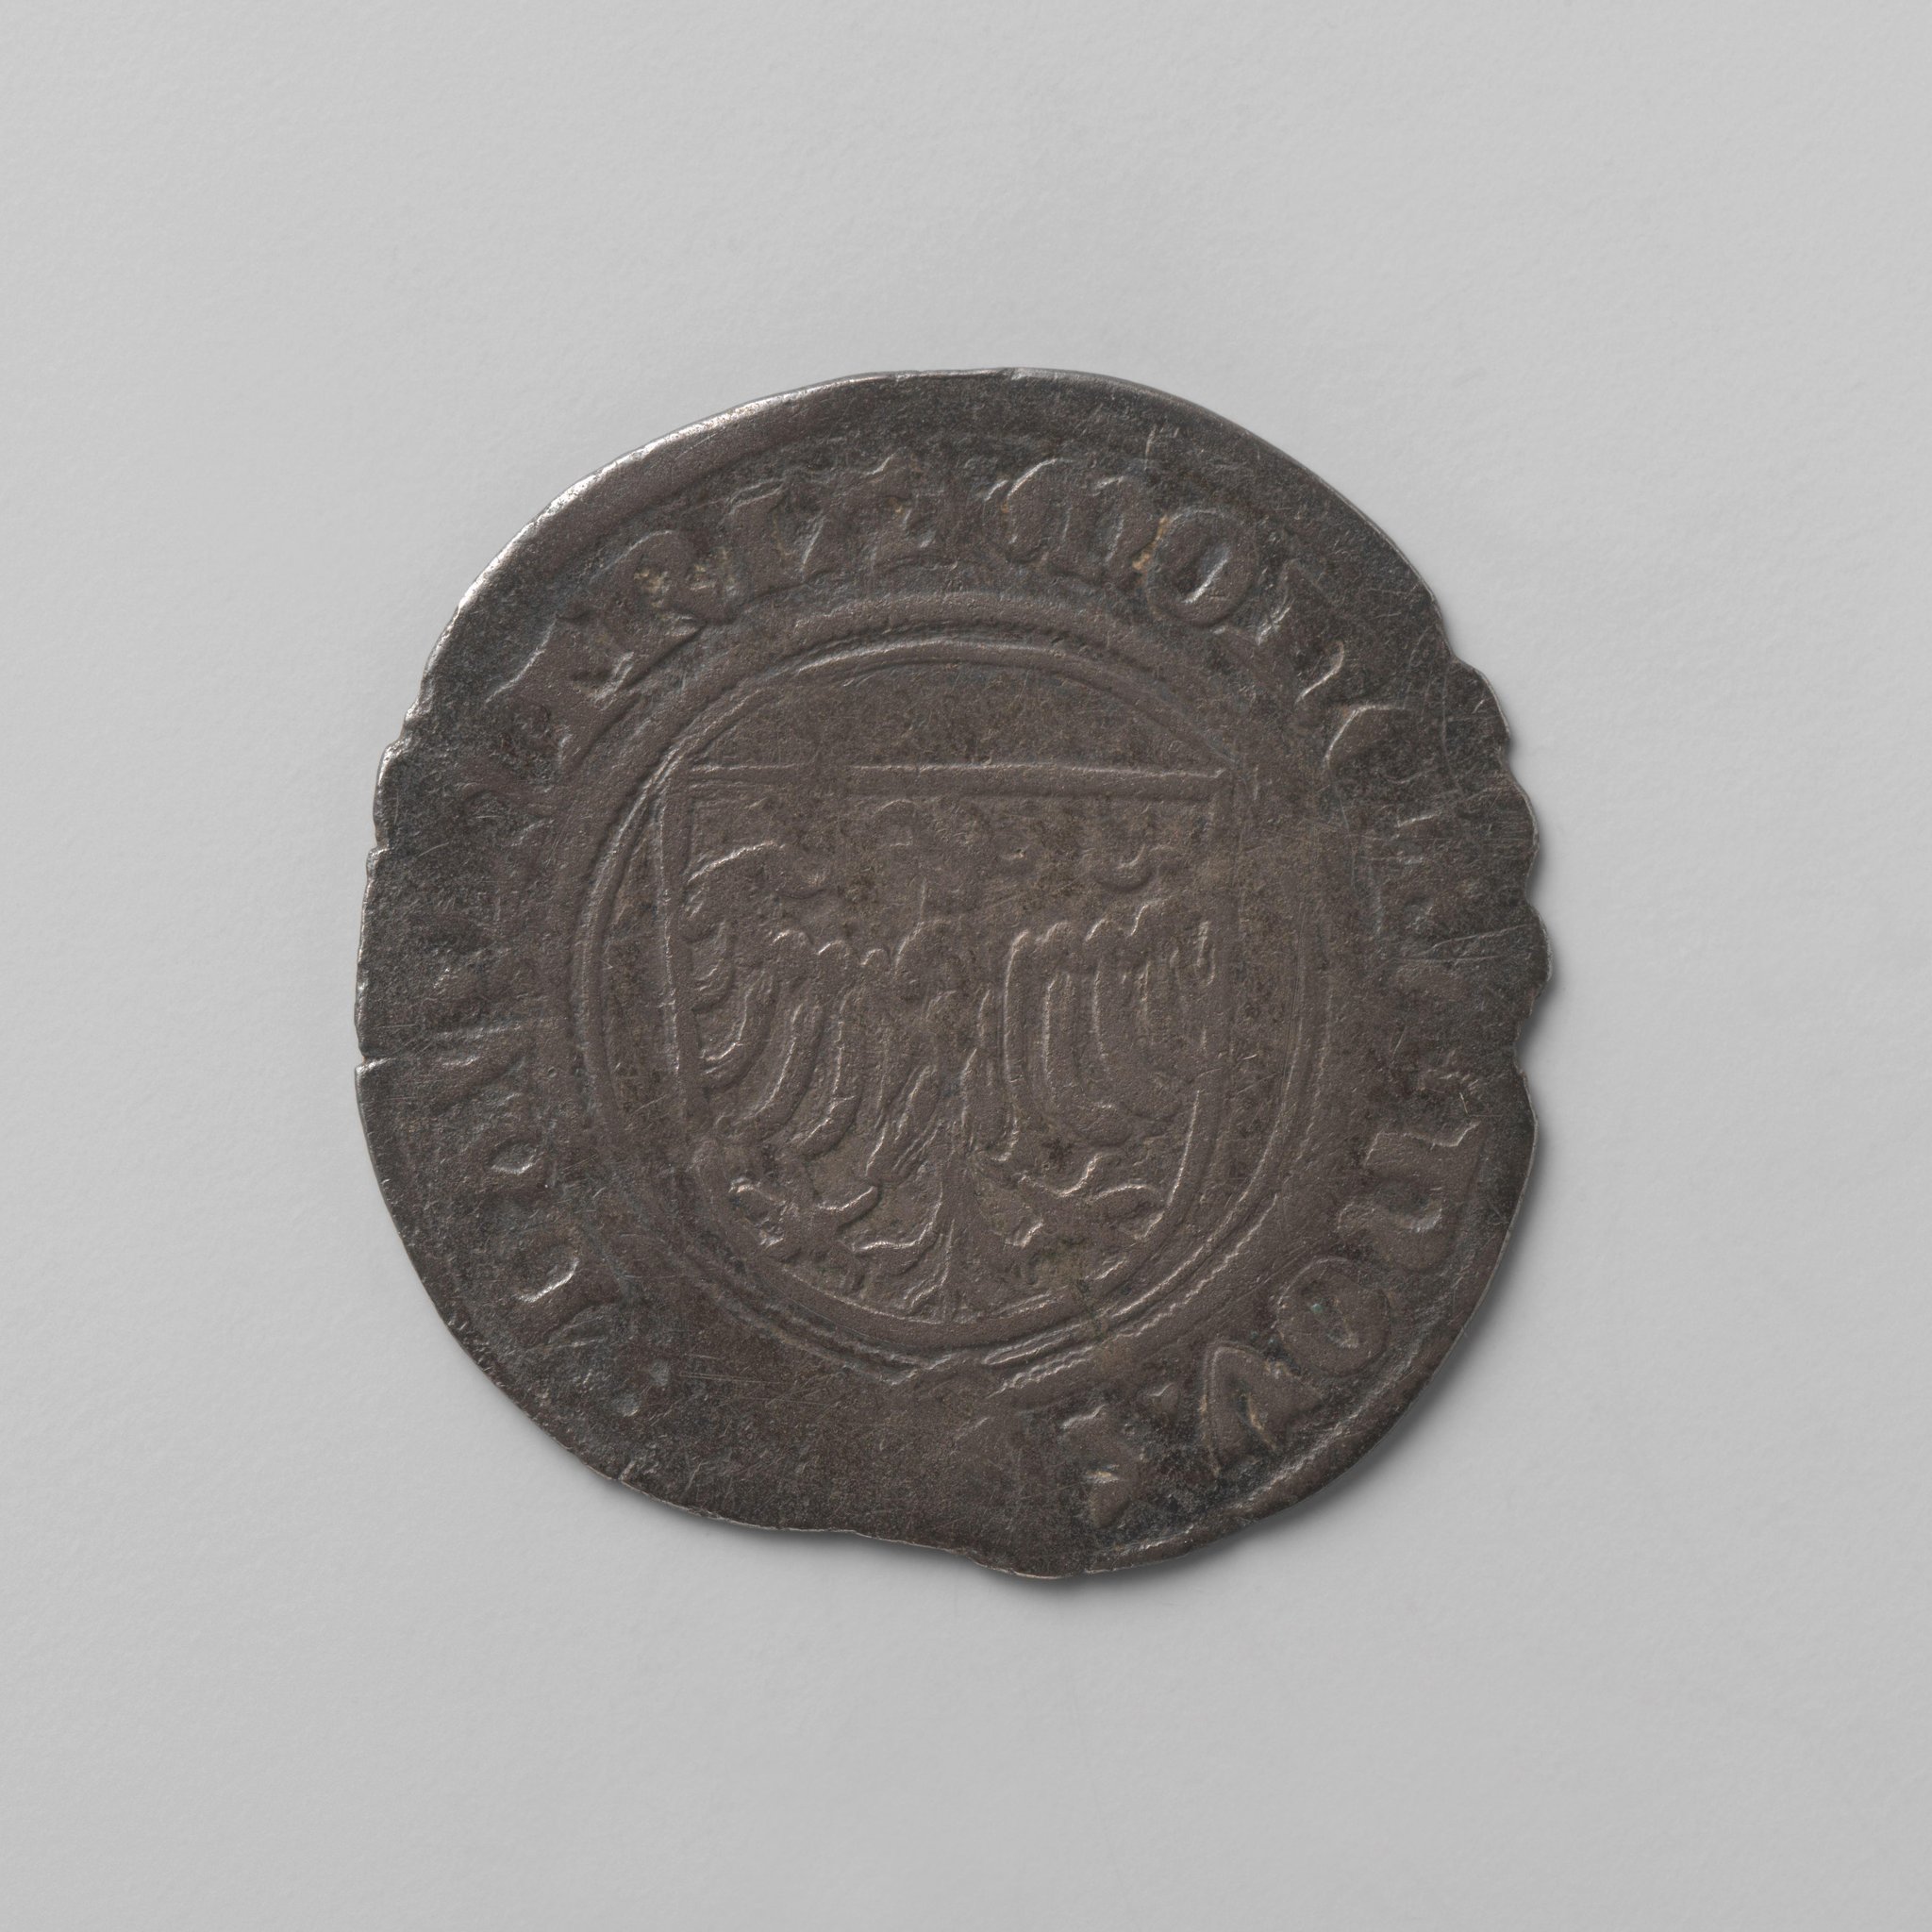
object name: coin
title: Deventer, witpenning, 1473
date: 1473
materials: silver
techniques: striking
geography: deventer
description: Zilveren munt. Voorzijde: wapenschild van Deventer, waaronder schuin geplaatst wapenschild van Oversticht. Keerzijde: wapenschild van bisschop David van Bourgondië op lang gevoet kruis met in de hoeken cirkeltjes.